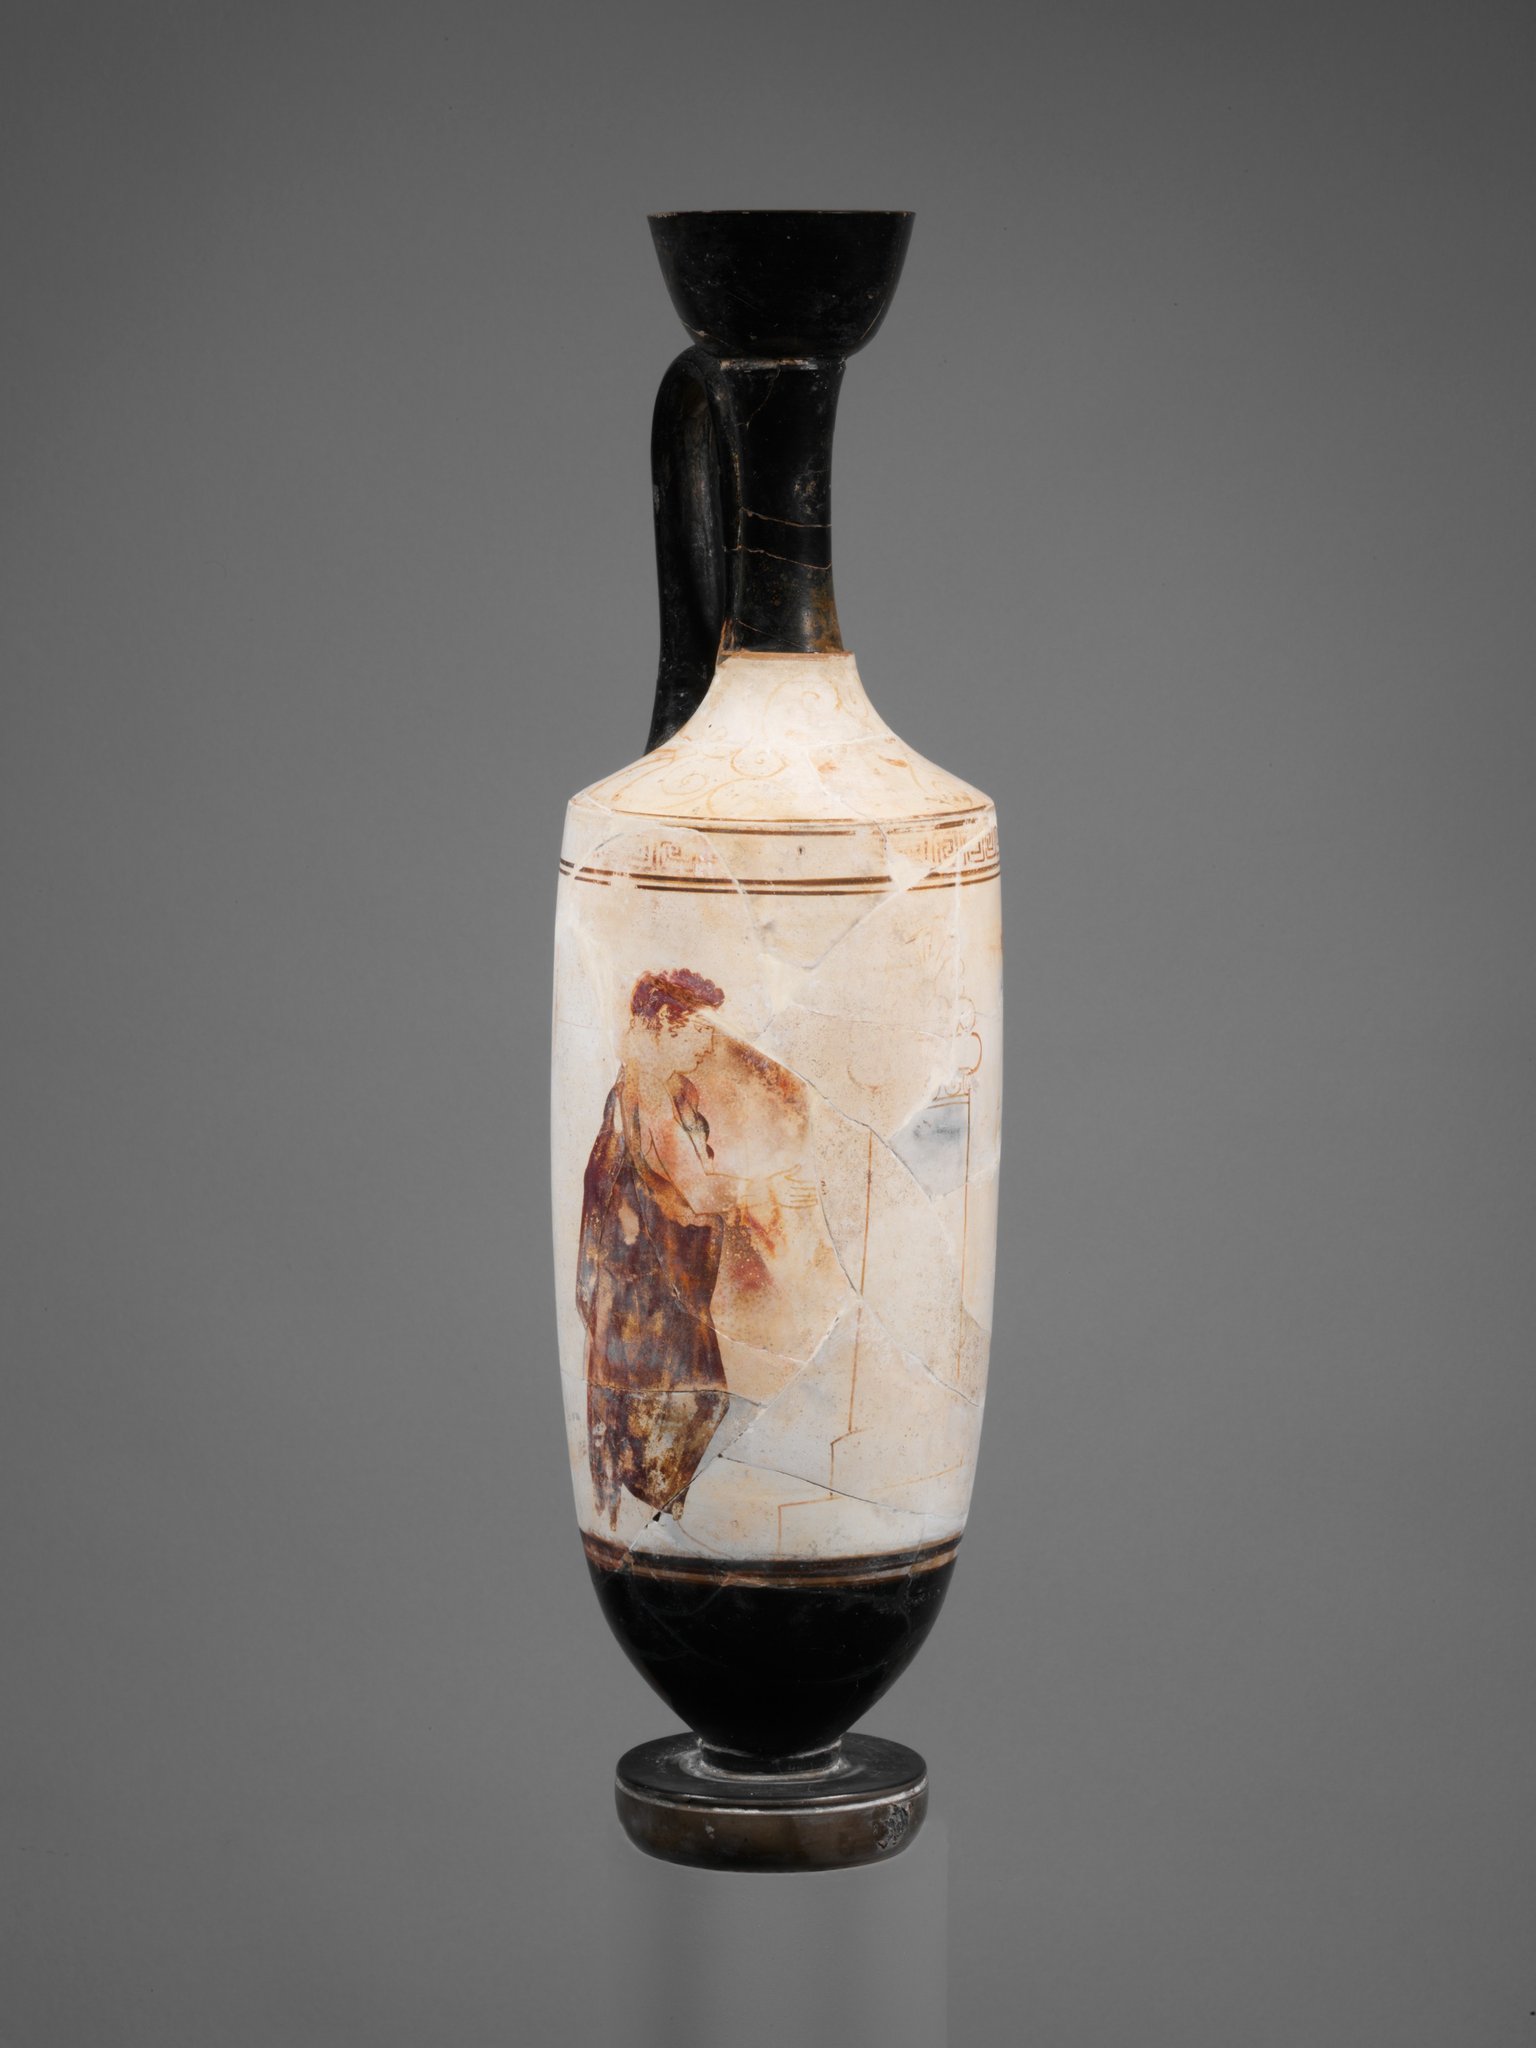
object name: lekythos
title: Terracotta lekythos (oil flask)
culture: greek, attic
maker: bird painter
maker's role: artist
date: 420 BCE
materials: terracotta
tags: women